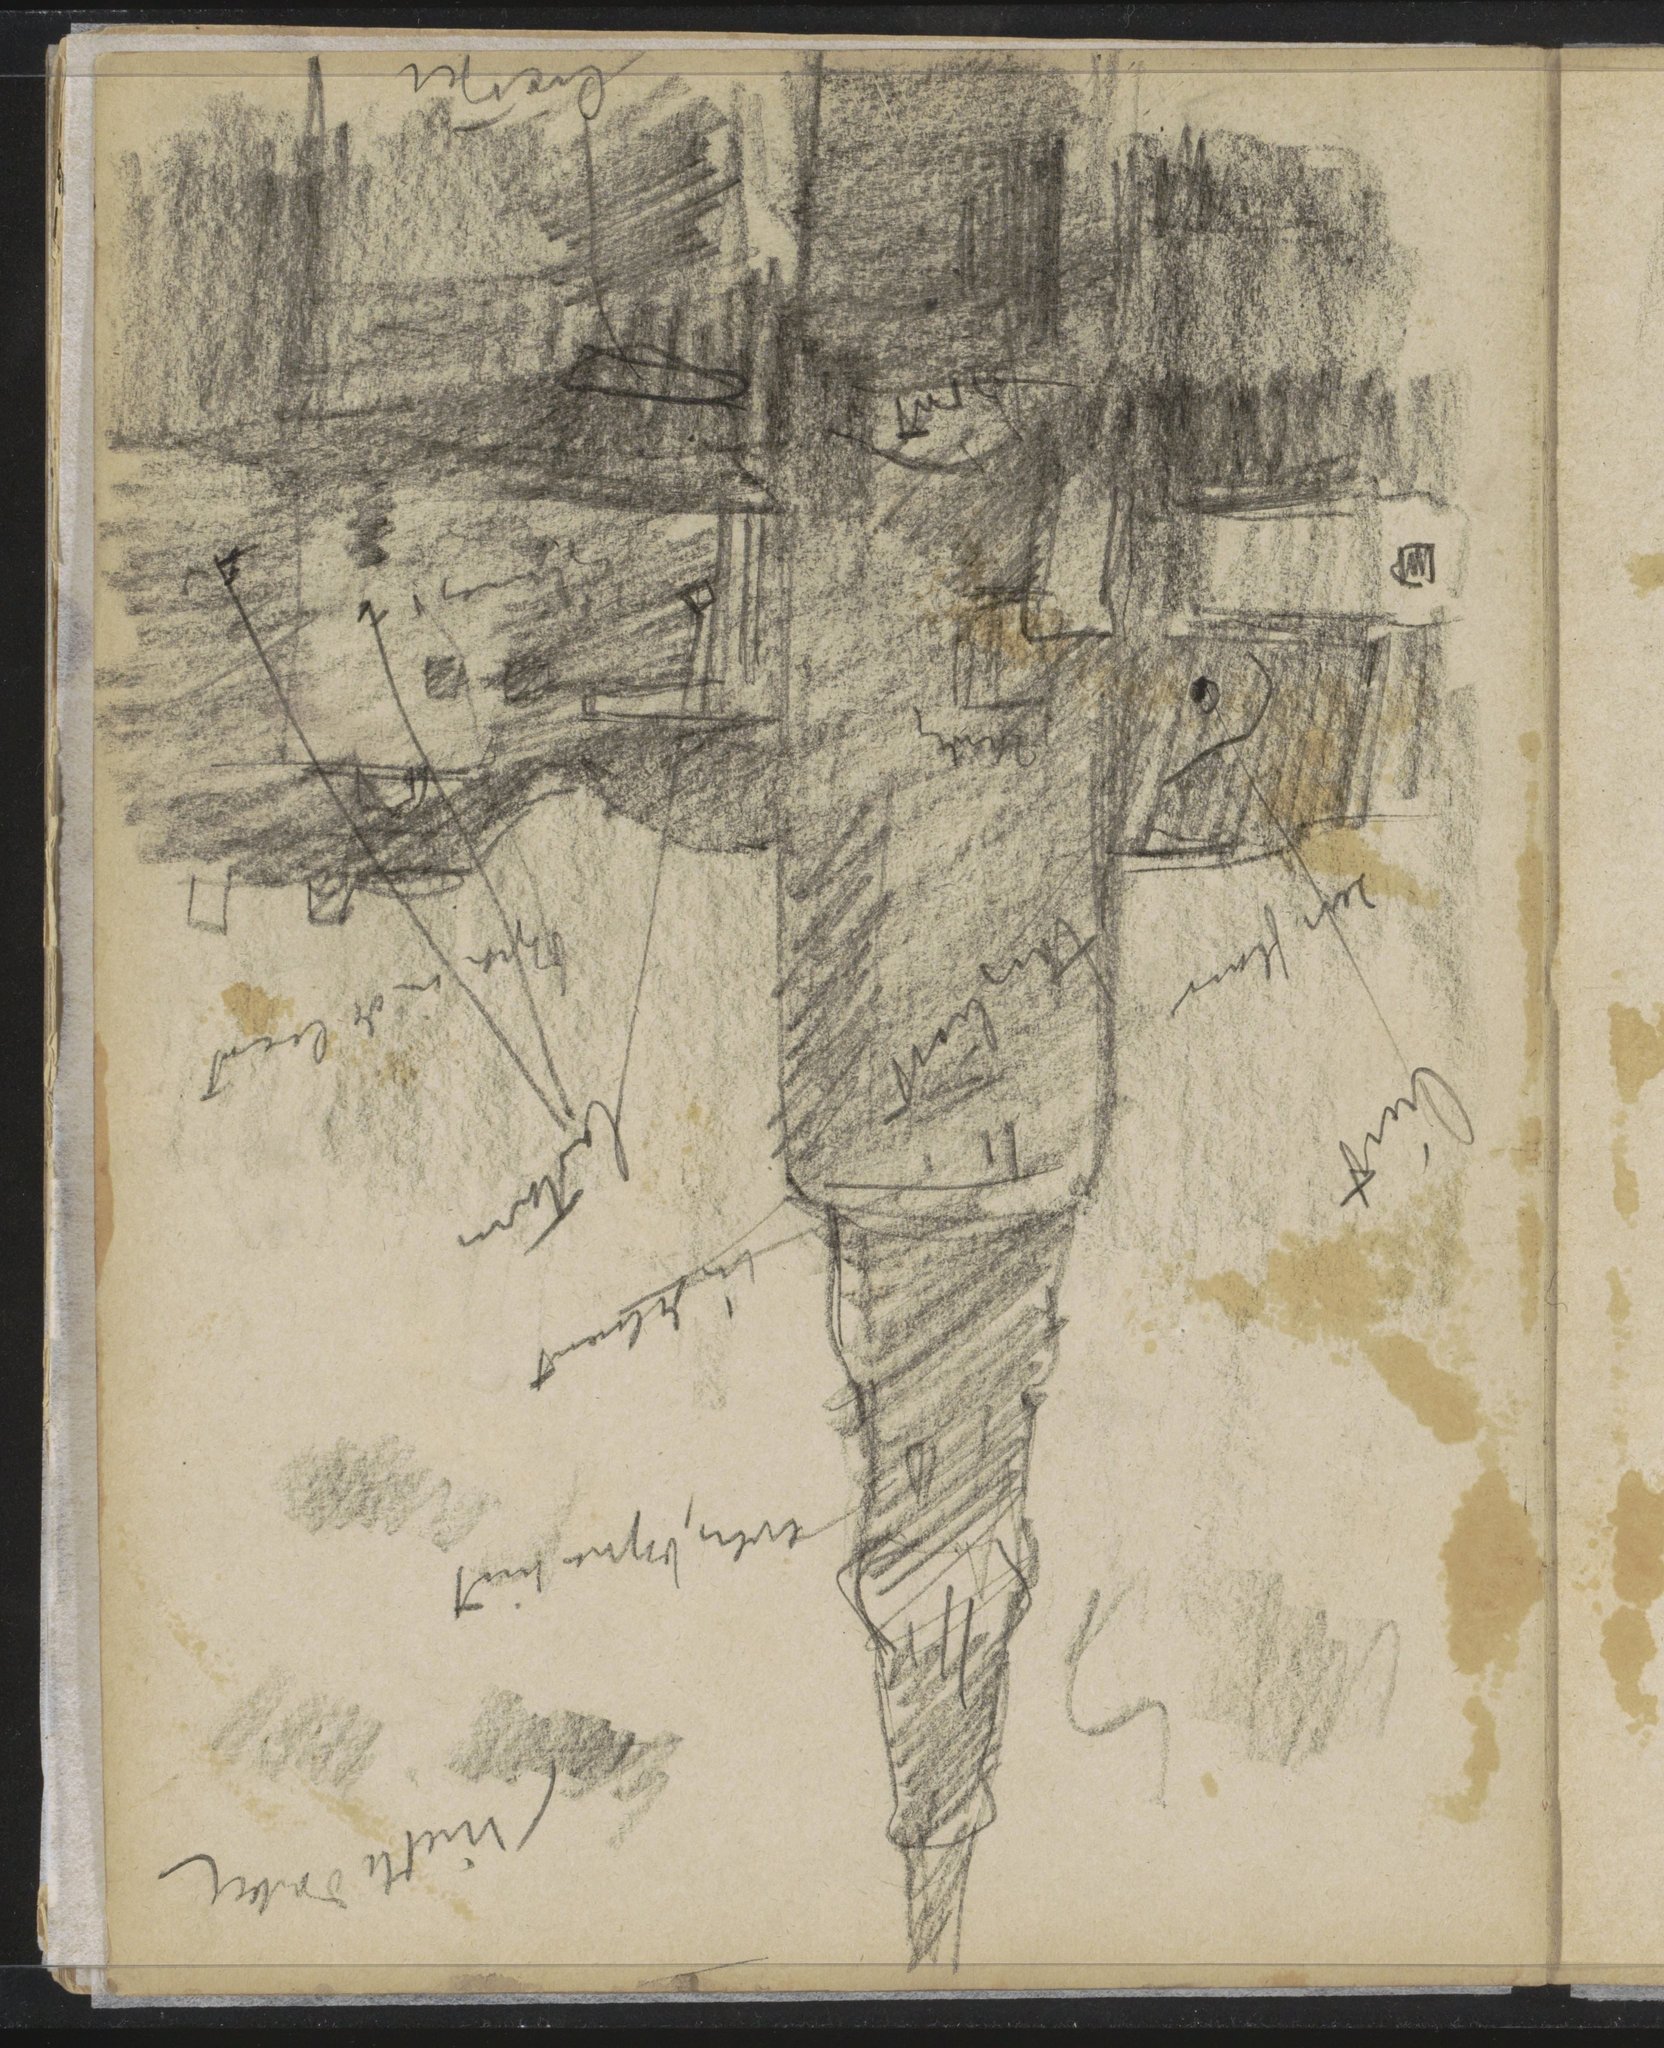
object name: sketchbook leaf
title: Gezicht op de Montelbaanstoren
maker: willem witsen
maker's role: draughtsman, painter, print maker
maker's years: 1860-1923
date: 1887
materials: chalk, paper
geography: amsterdam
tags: canals, waters (in city)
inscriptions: kleurnotitie, handgeschreven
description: Pagina 54 uit een schetsboek met 29 bladen.